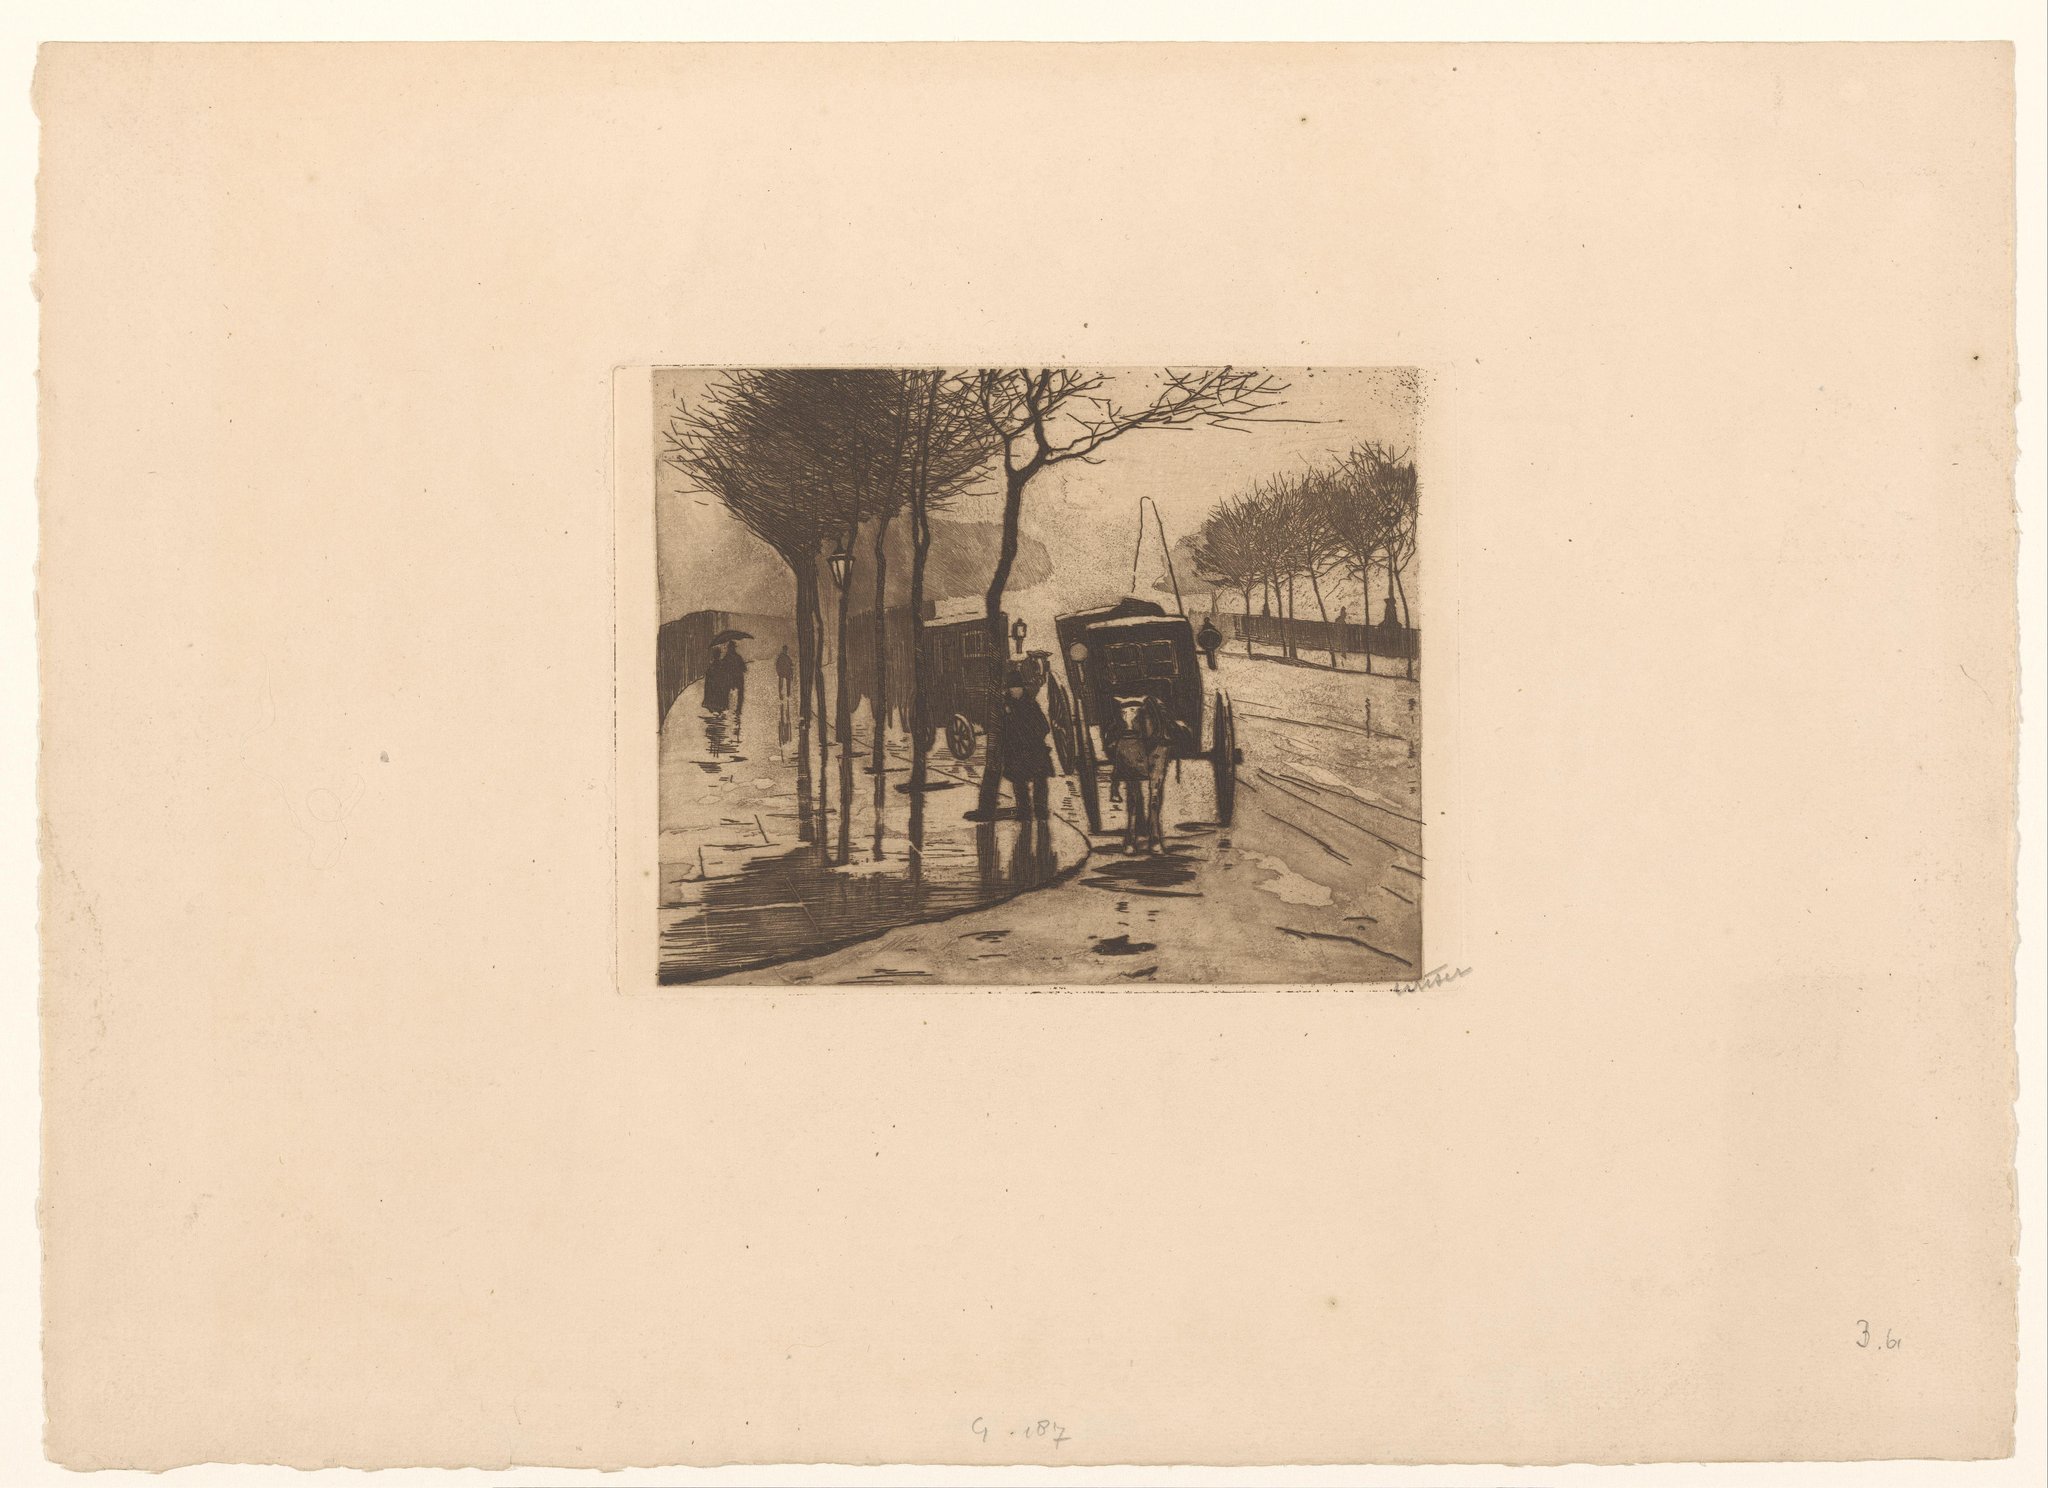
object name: print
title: Wachtende rijtuigen op de Victoria Embankment in Londen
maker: willem witsen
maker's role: draughtsman, painter, print maker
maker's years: 1860-1923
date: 1890-1908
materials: paper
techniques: aquatint, etching, intaglio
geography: london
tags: trees, horse, passenger carriage, public road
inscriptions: signature: ‘Witsen’, watermark, collector's mark: Lugt 2228